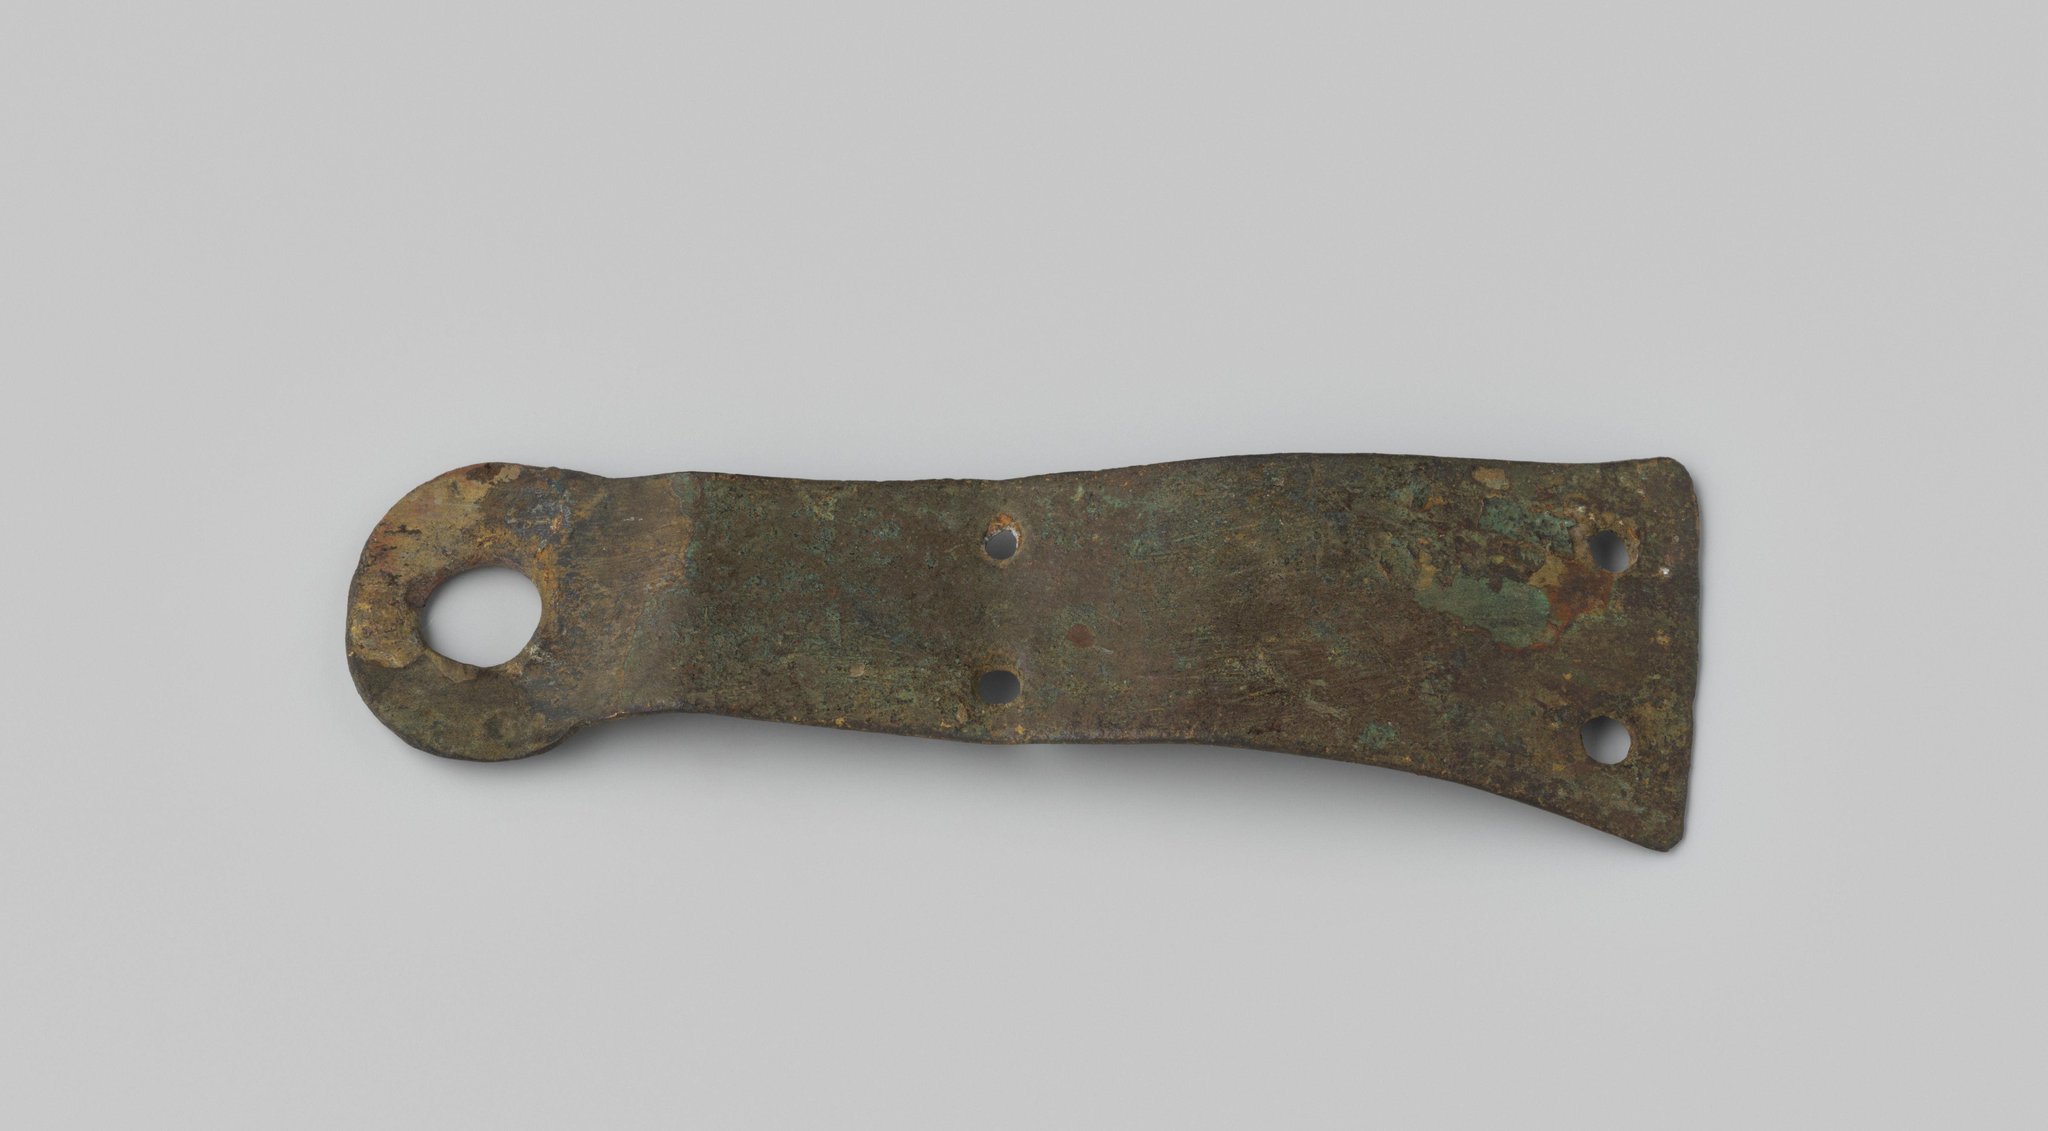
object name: hasp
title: Beugel uit het wrak van de Oost-Indiëvaarder Hollandia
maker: Anonymous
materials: copper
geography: netherlands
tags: verenigde oostindische compagnie, hollandia (schip), annet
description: Locks, fastenings and accessories, hasp; flat strip, tapering towards circular end with circular slot, 2 pairs of holes.